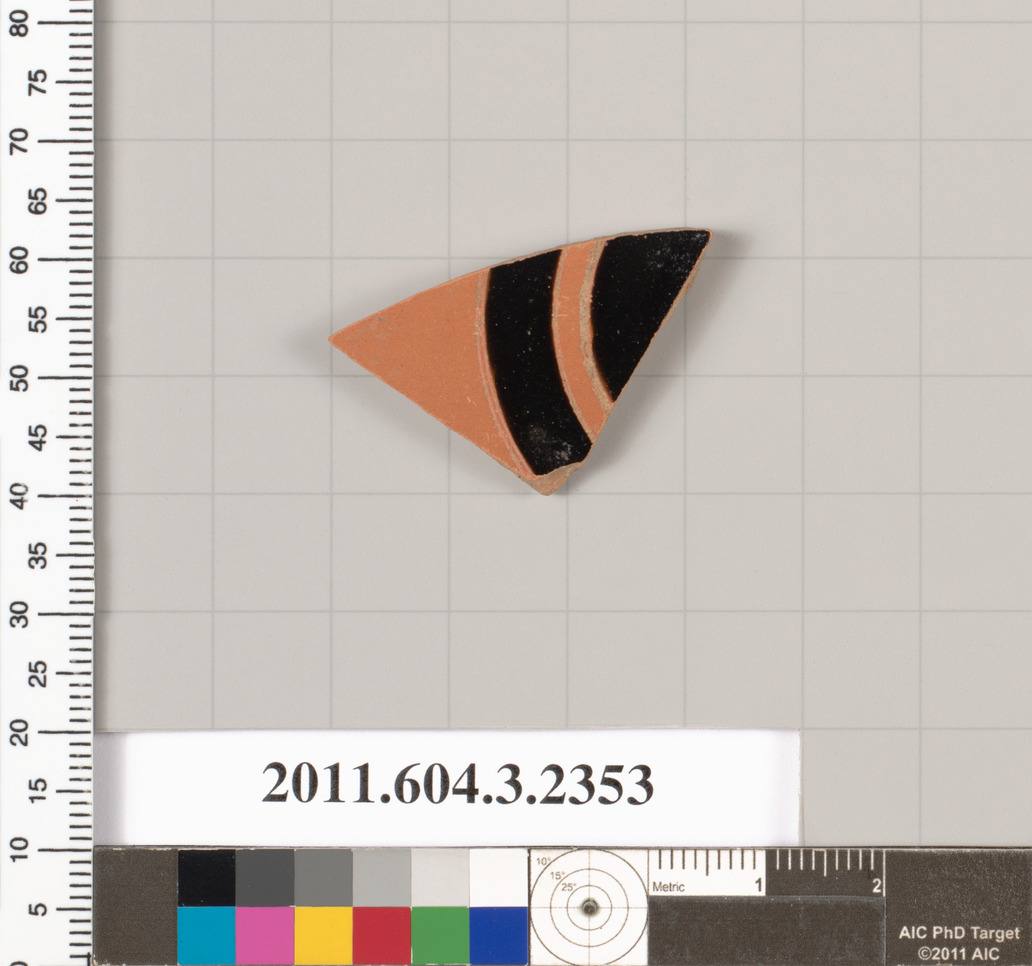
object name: kylix fragment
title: Terracotta fragment of a kylix: eye-cup (drinking cup)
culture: greek, attic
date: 540-520 BCE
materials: terracotta